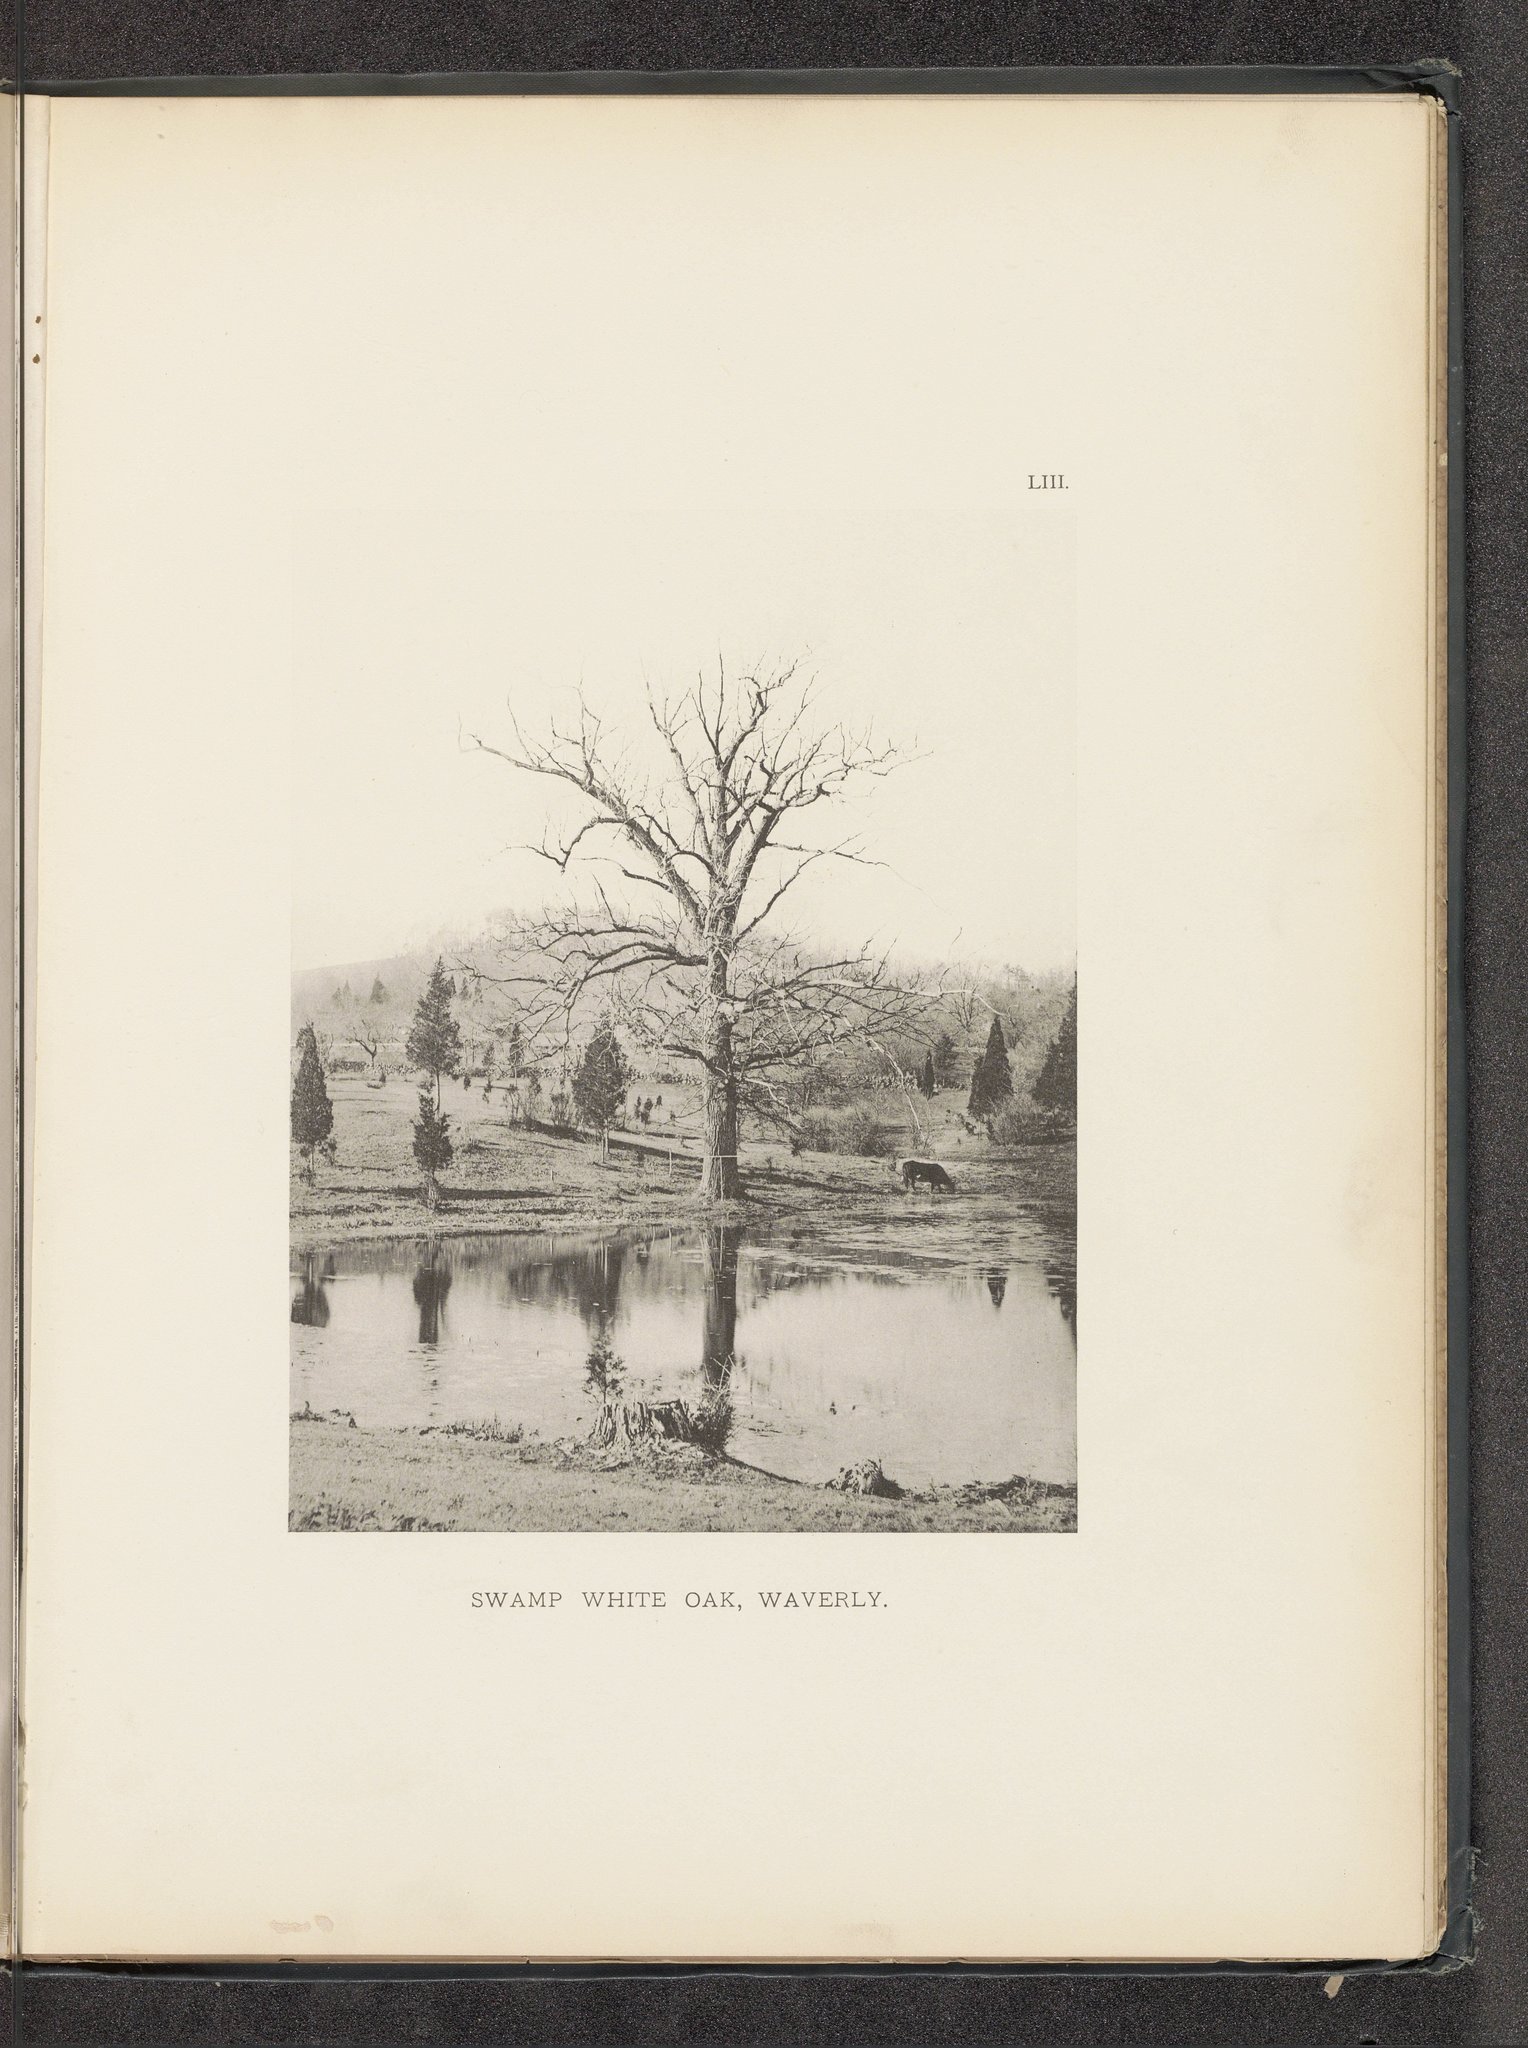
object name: photomechanical print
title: Swamp white oak, Waverly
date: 1880-1890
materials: paper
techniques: photograph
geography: massachusetts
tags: swamp, inland marsh, fens, trees: oak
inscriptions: number: ‘LIII.’